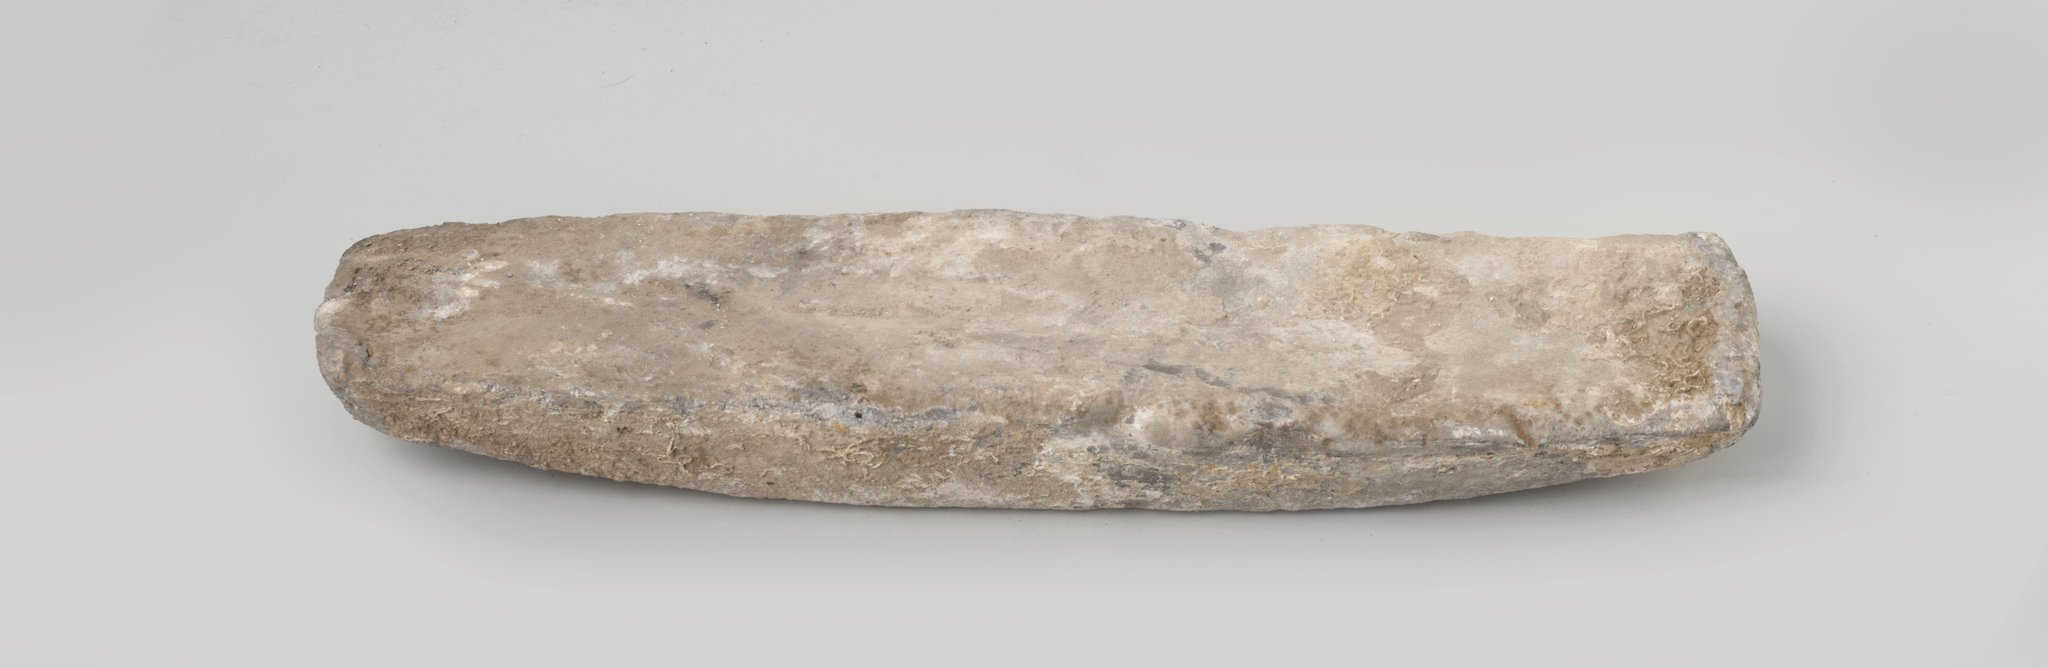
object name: ingot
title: Ballastlood uit het wrak van de Oost-Indiëvaarder Hollandia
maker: Anonymous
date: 1700-1743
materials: lead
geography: netherlands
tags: verenigde oostindische compagnie, hollandia (schip), annet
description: Ingot; (1) corroded, oblong rectangular, slightly tapered ends, (69.5l, 15-17w, 8h), tapered underside, no marks visible.